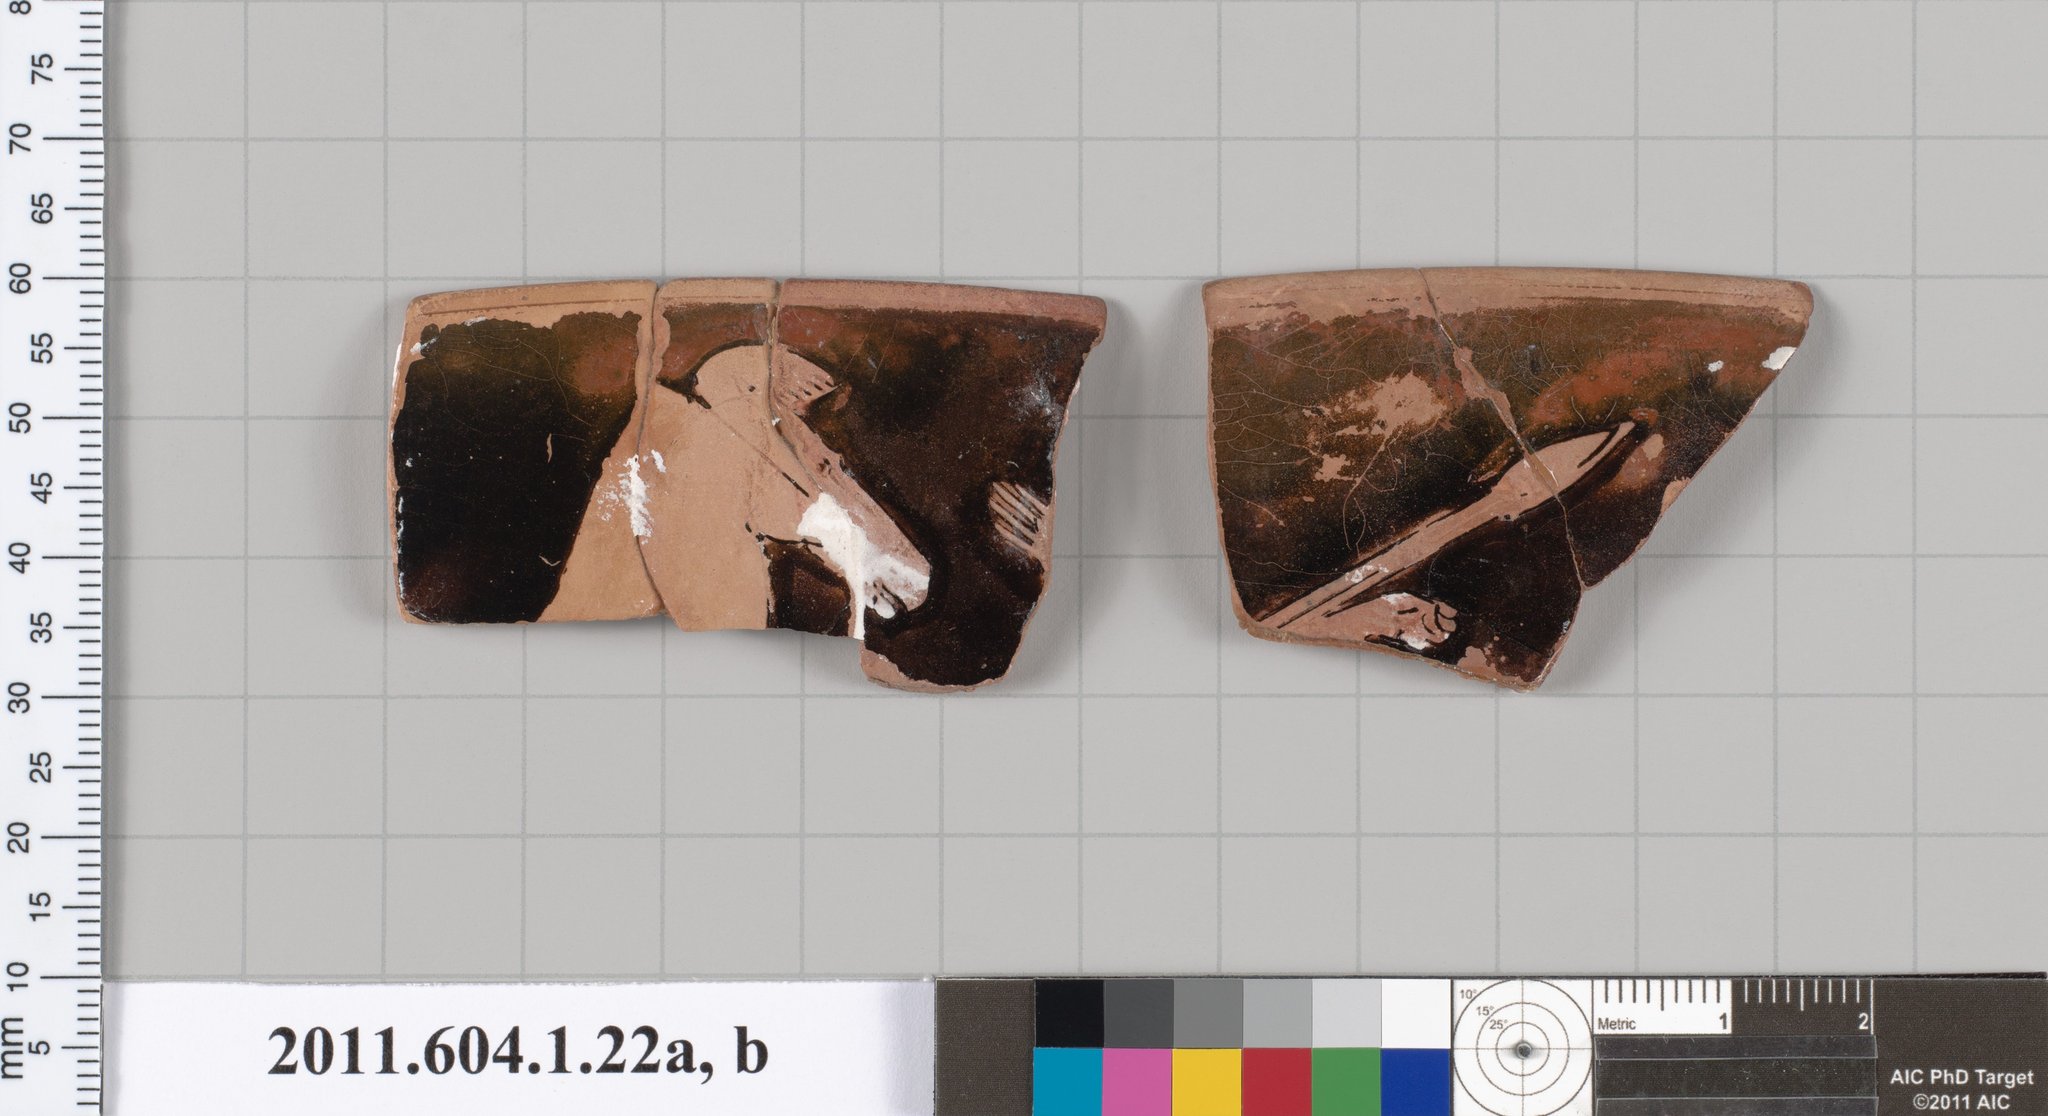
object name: kylix fragment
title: Terracotta rim fragments of a kylix (drinking cup)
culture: greek, attic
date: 475-451 BCE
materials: terracotta